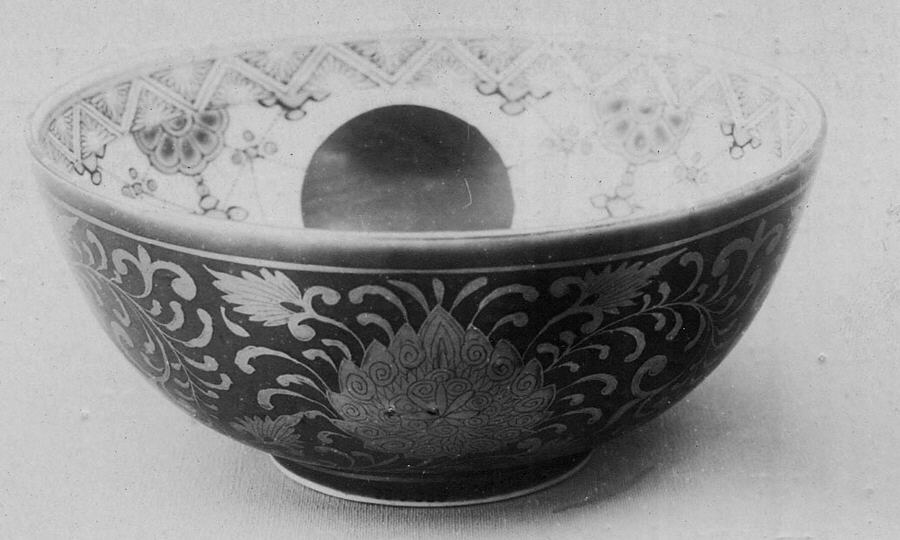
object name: saucer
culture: japanese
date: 1780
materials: enamel, glaze, gold, porcelain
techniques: painting, polychrome